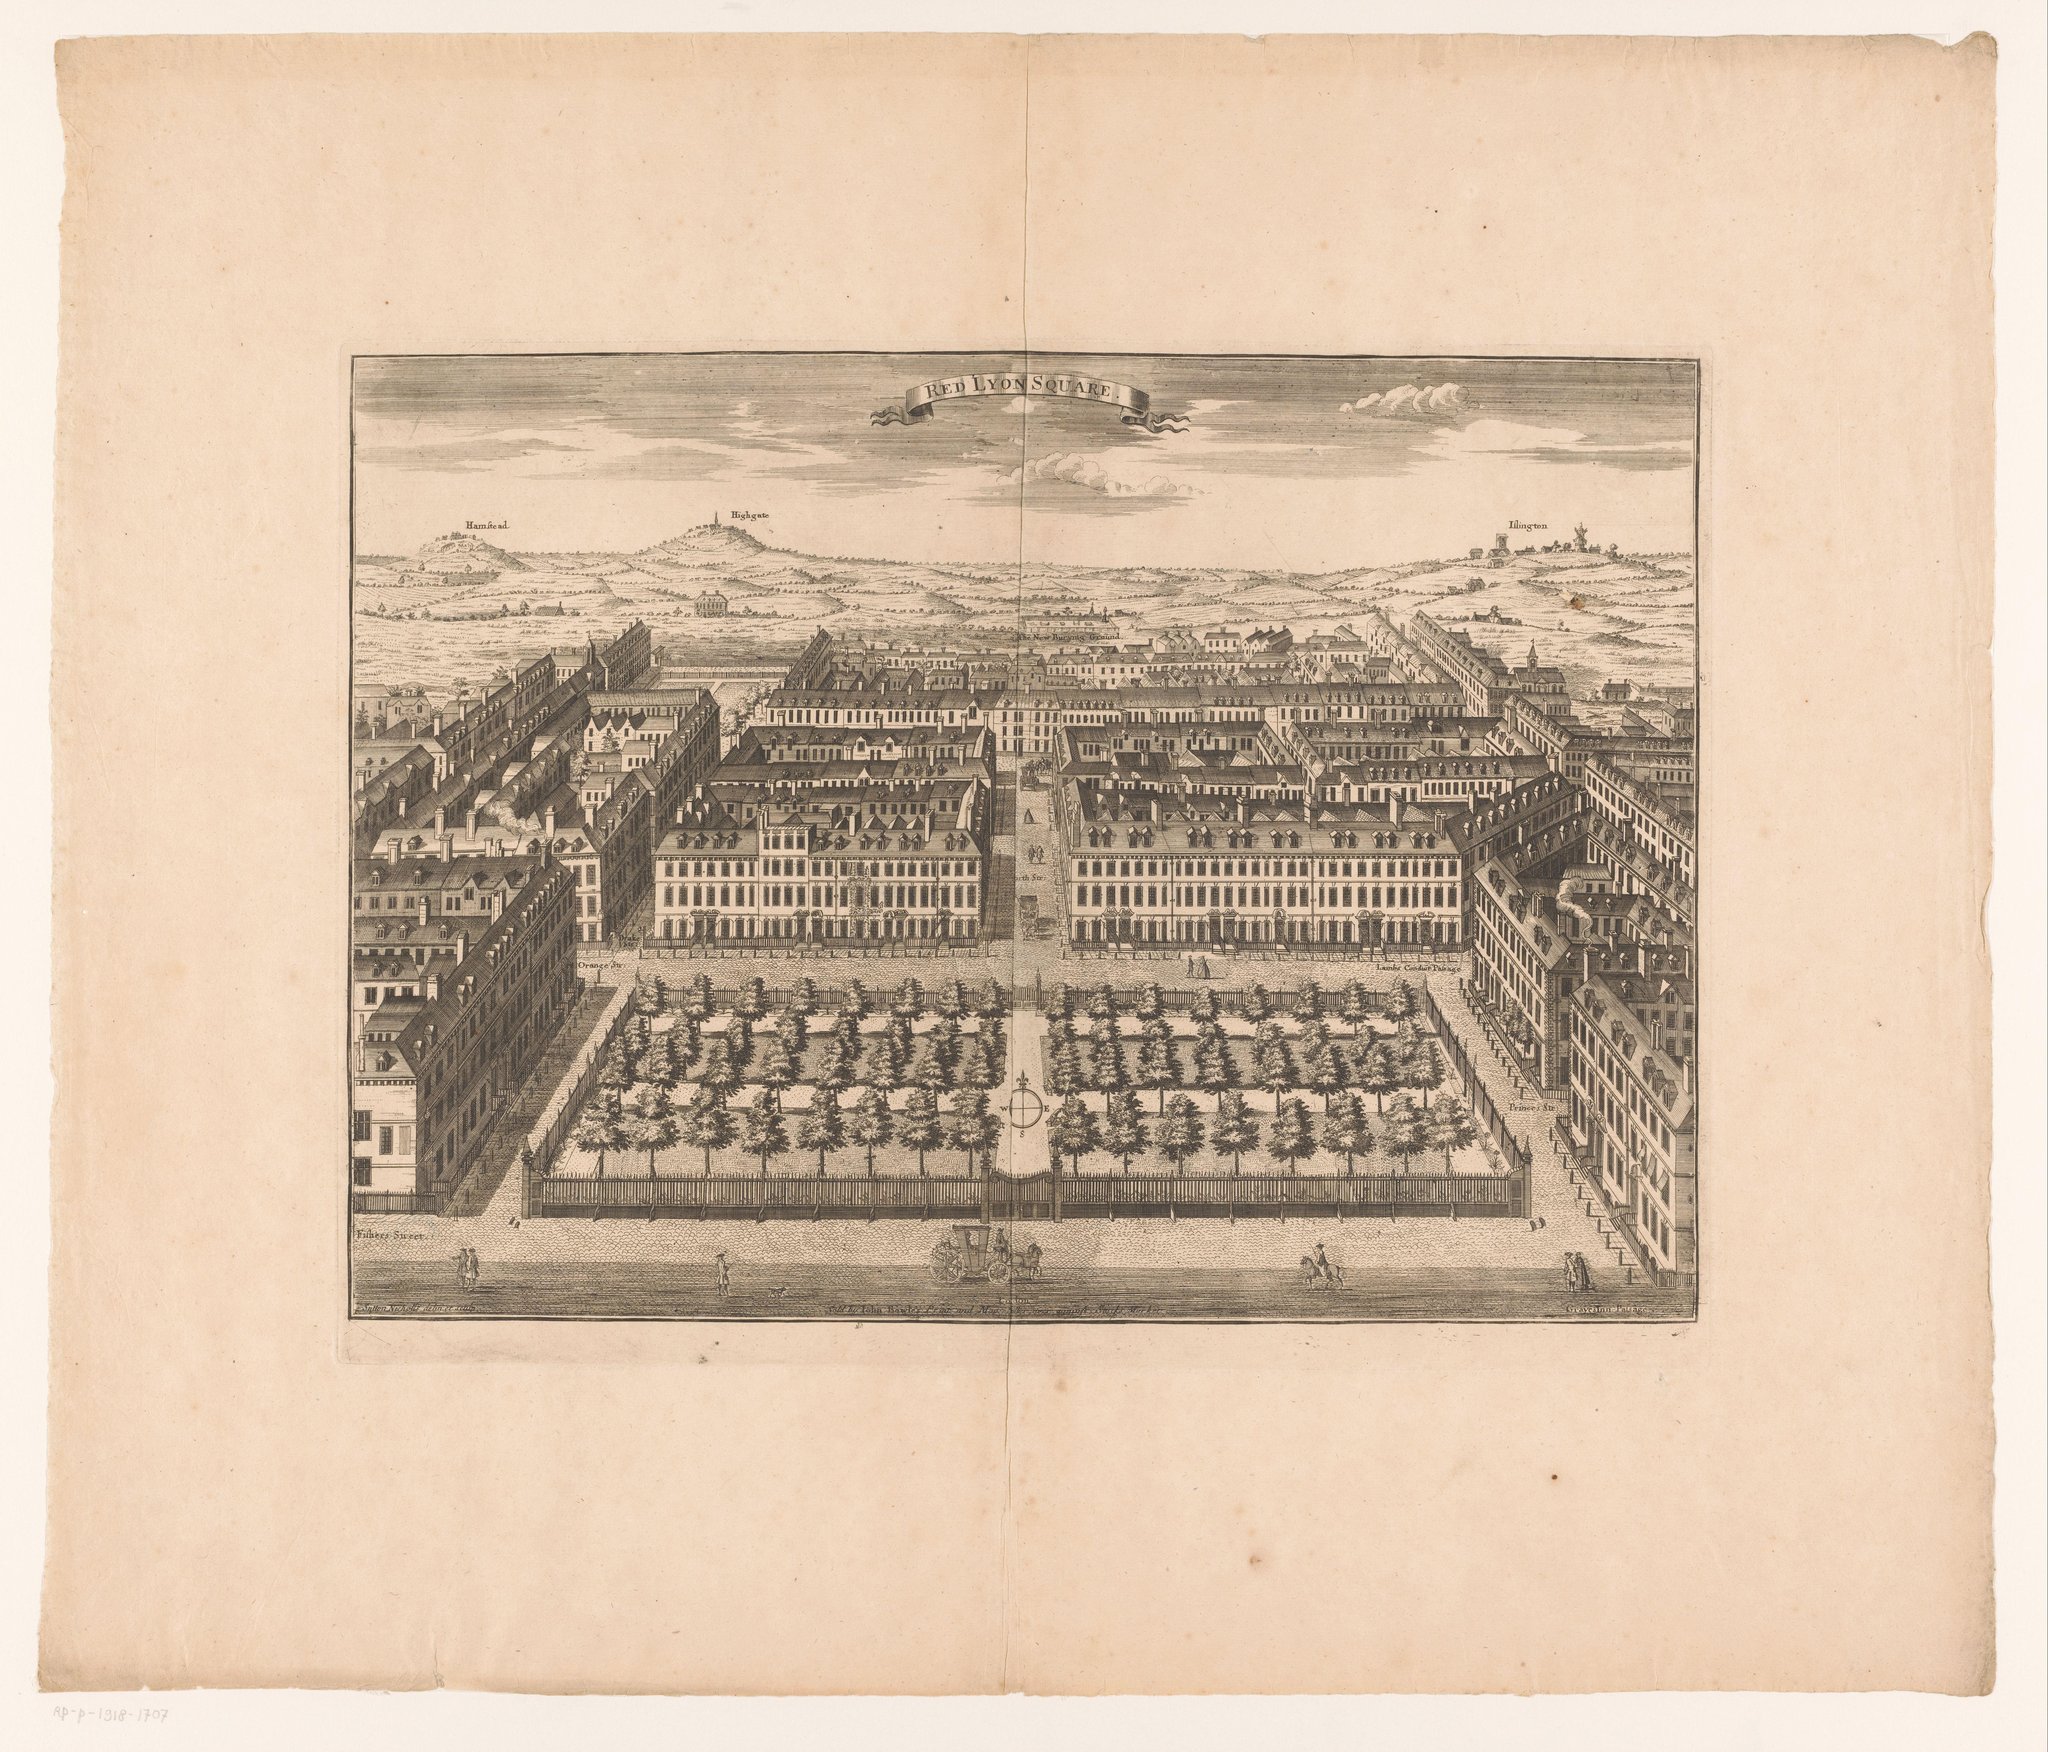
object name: print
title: Gezichten op gebouwen in Londen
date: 1720-1731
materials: paper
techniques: engraving, etching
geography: london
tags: square, place, circus, etc.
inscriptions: collector's mark: Lugt 2233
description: Deze reeks werd voor het eerst compleet uitgegeven in 1731, al zijn de losse prenten al voor die tijd uitgebracht. De meeste prenten zijn vervaardigd door Sutton Nicholls. De serie werd aangeboden voor verkoop door John Bowles in zijn catalogus 1753, op pagina 76, nummer 16.